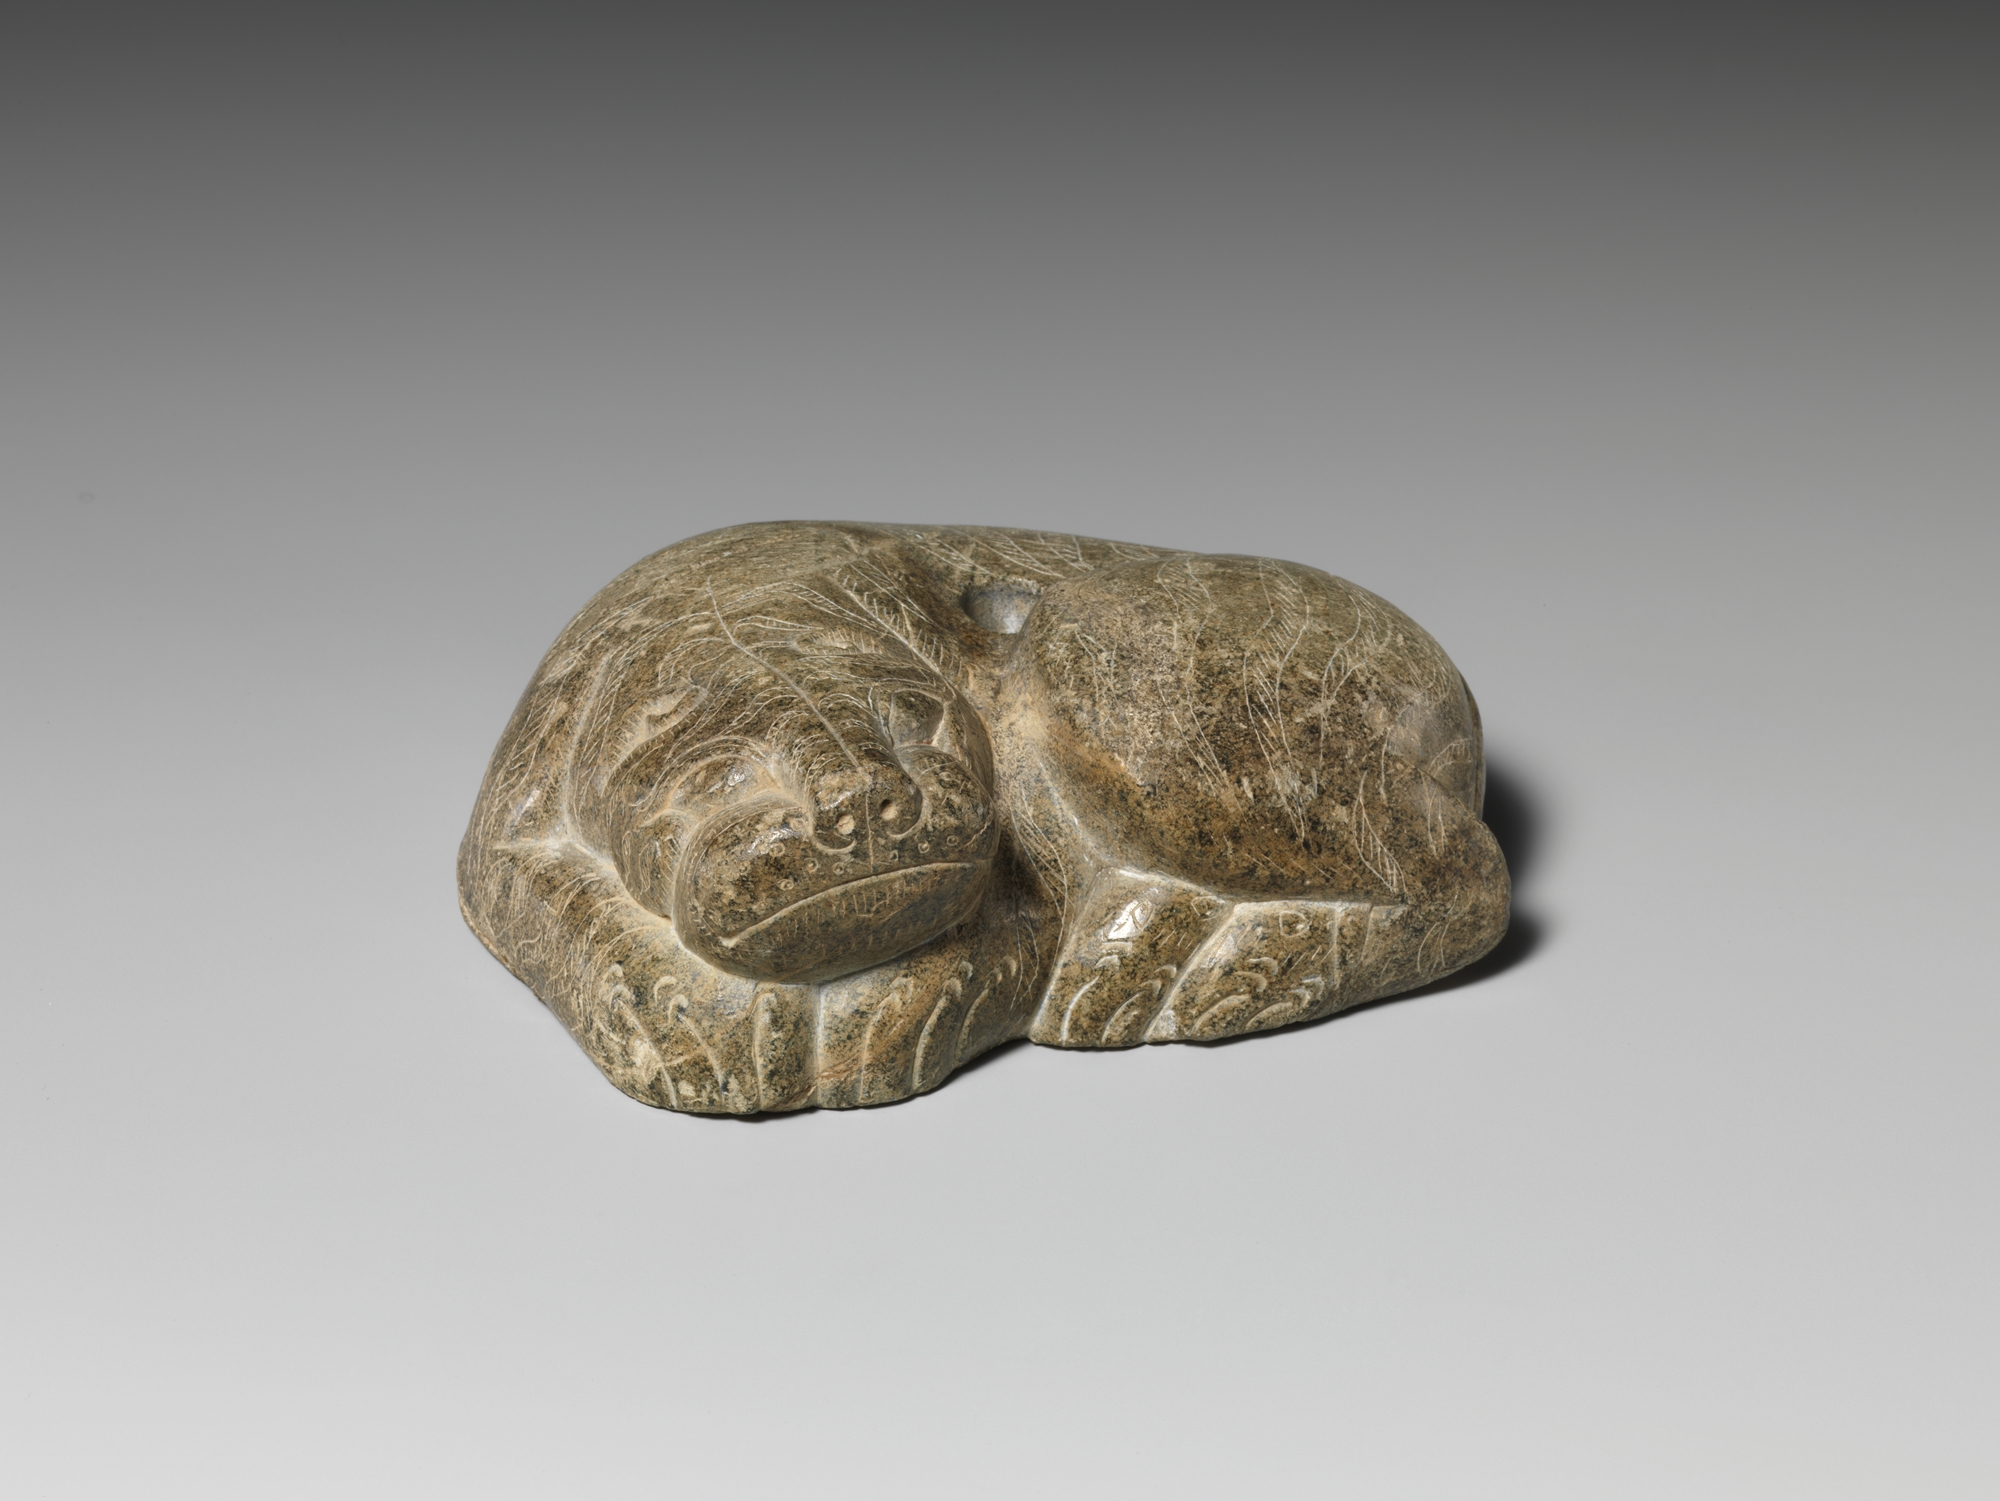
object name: pole base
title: Pole Base in the Form of a Tiger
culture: chinese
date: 206 BCE-220 CE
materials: stone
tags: tigers